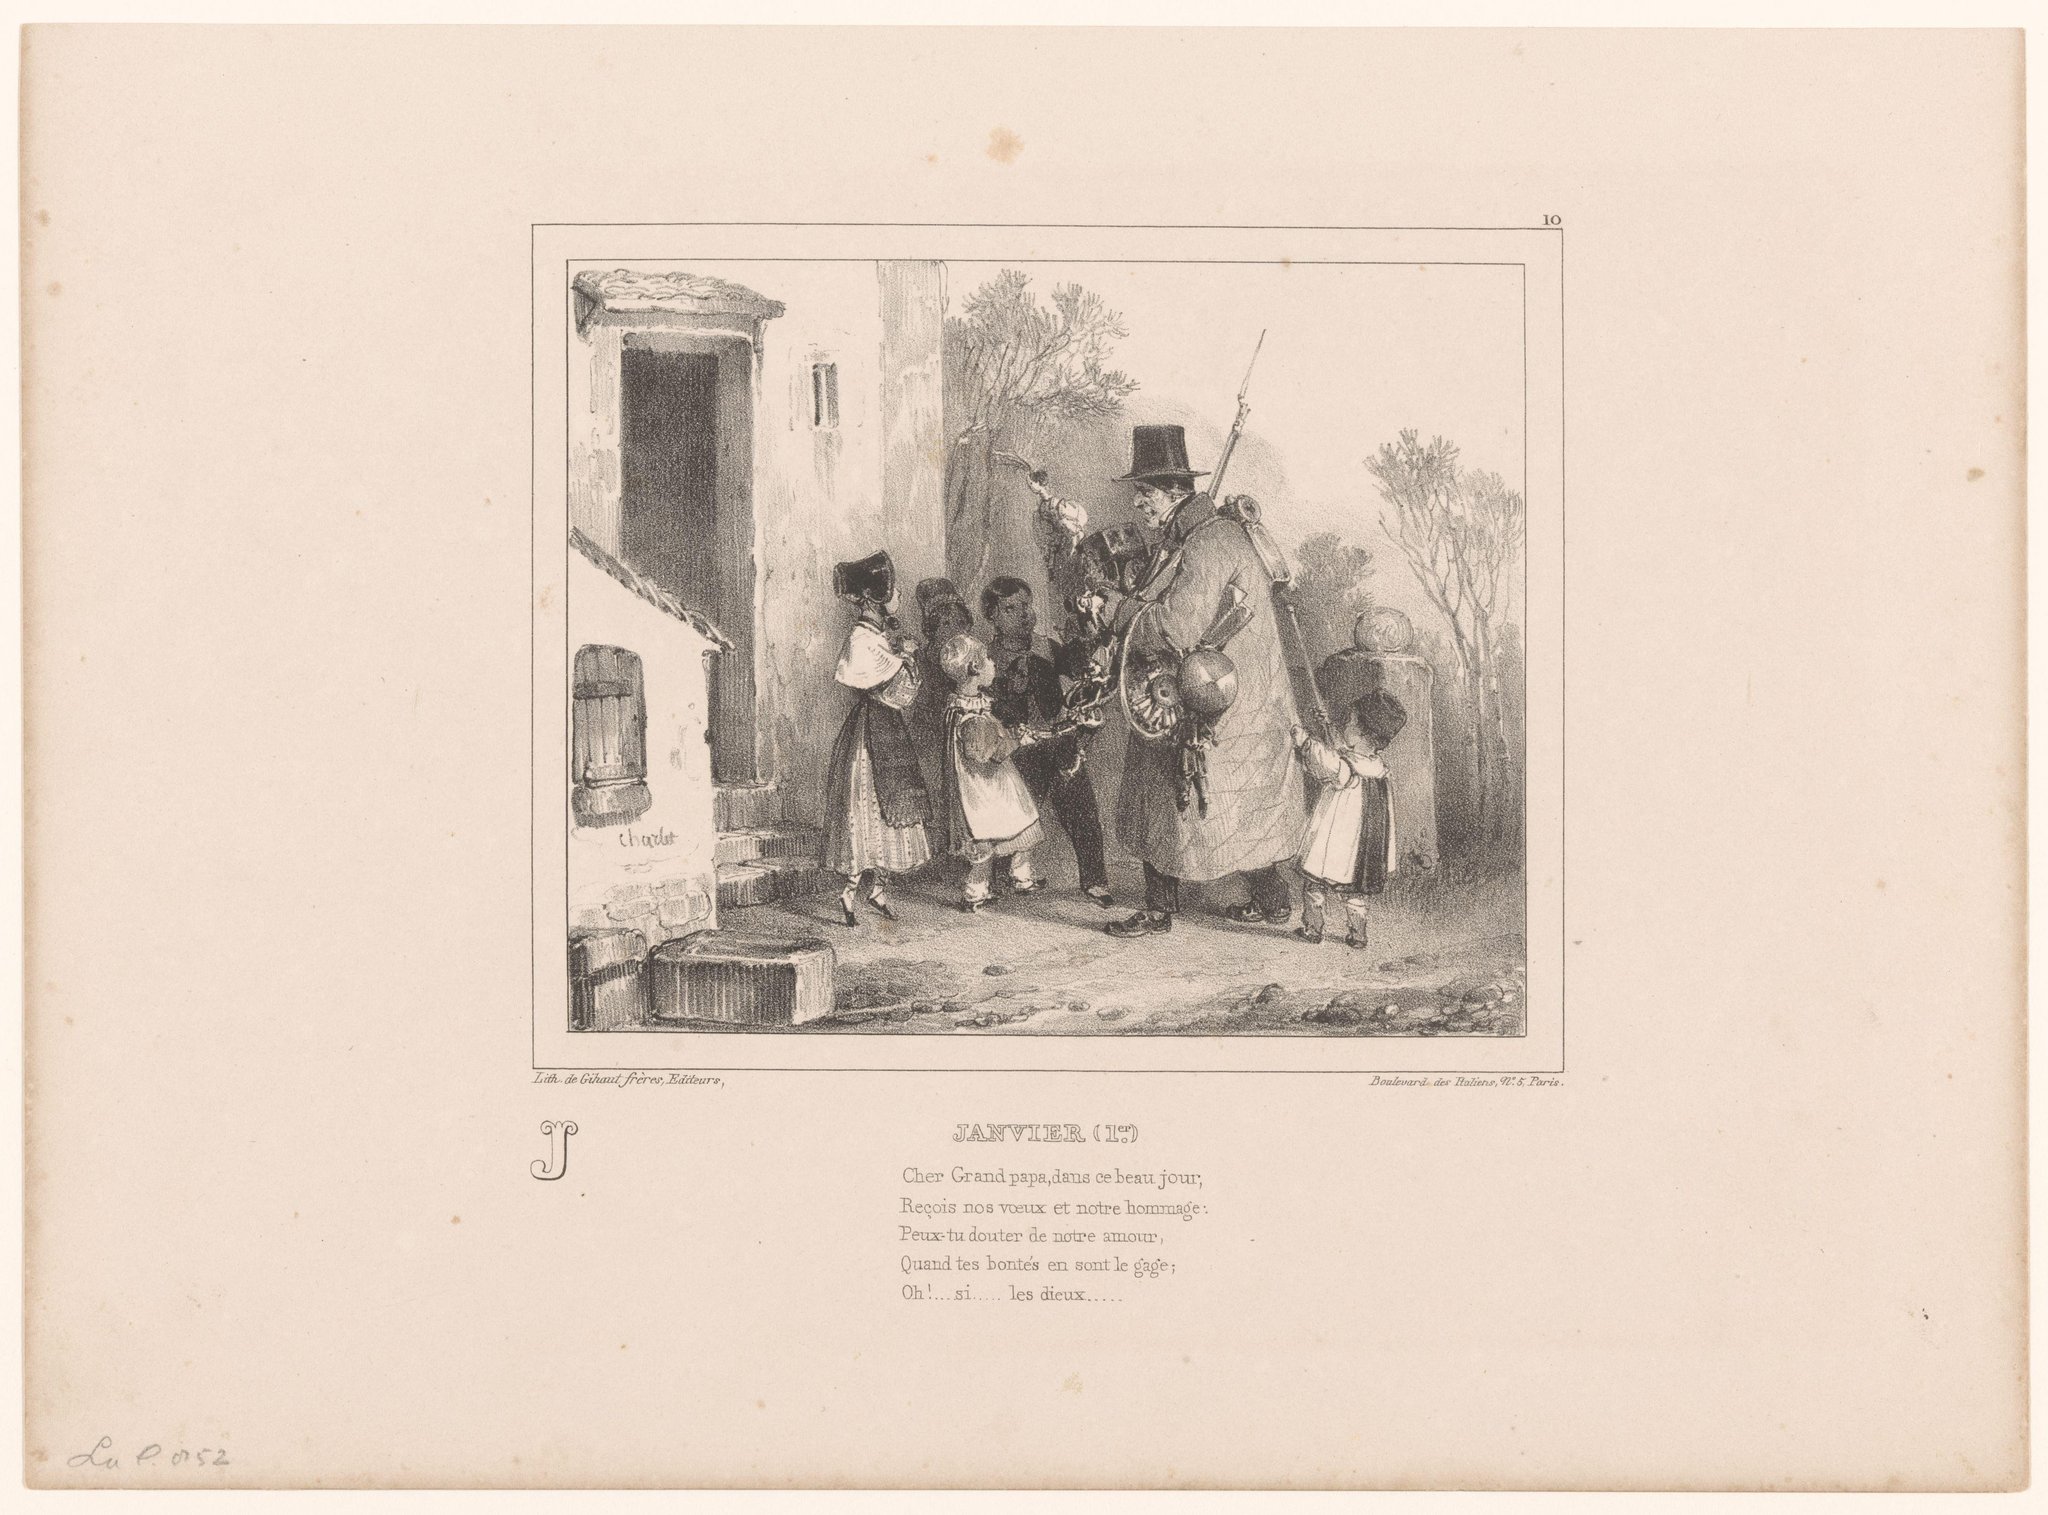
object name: print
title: Alfabet met een moraal voor kinderen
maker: nicolas toussaint charlet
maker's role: draughtsman, painter, print maker, printer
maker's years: 1792-1845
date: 1835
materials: paper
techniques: lithograph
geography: paris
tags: january 1 (~ festivities), grandparent(s) with grandchild(ren) (family group), (playing with) toys, bringing gifts; exchanging gifts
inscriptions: collector's mark: Lugt 2228a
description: Een vrijgevige, met speelgoed beladen grootvader, wordt omringd door vijf kleinkinderen die hem een gelukkig nieuwjaar wensen.